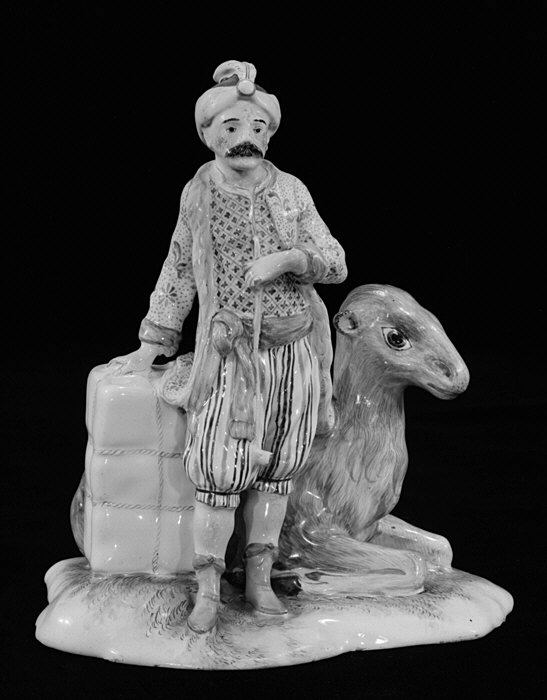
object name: group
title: Turk and camel (representing Asia) (part of a set)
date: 1755-1770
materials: faience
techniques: glazing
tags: animals,men